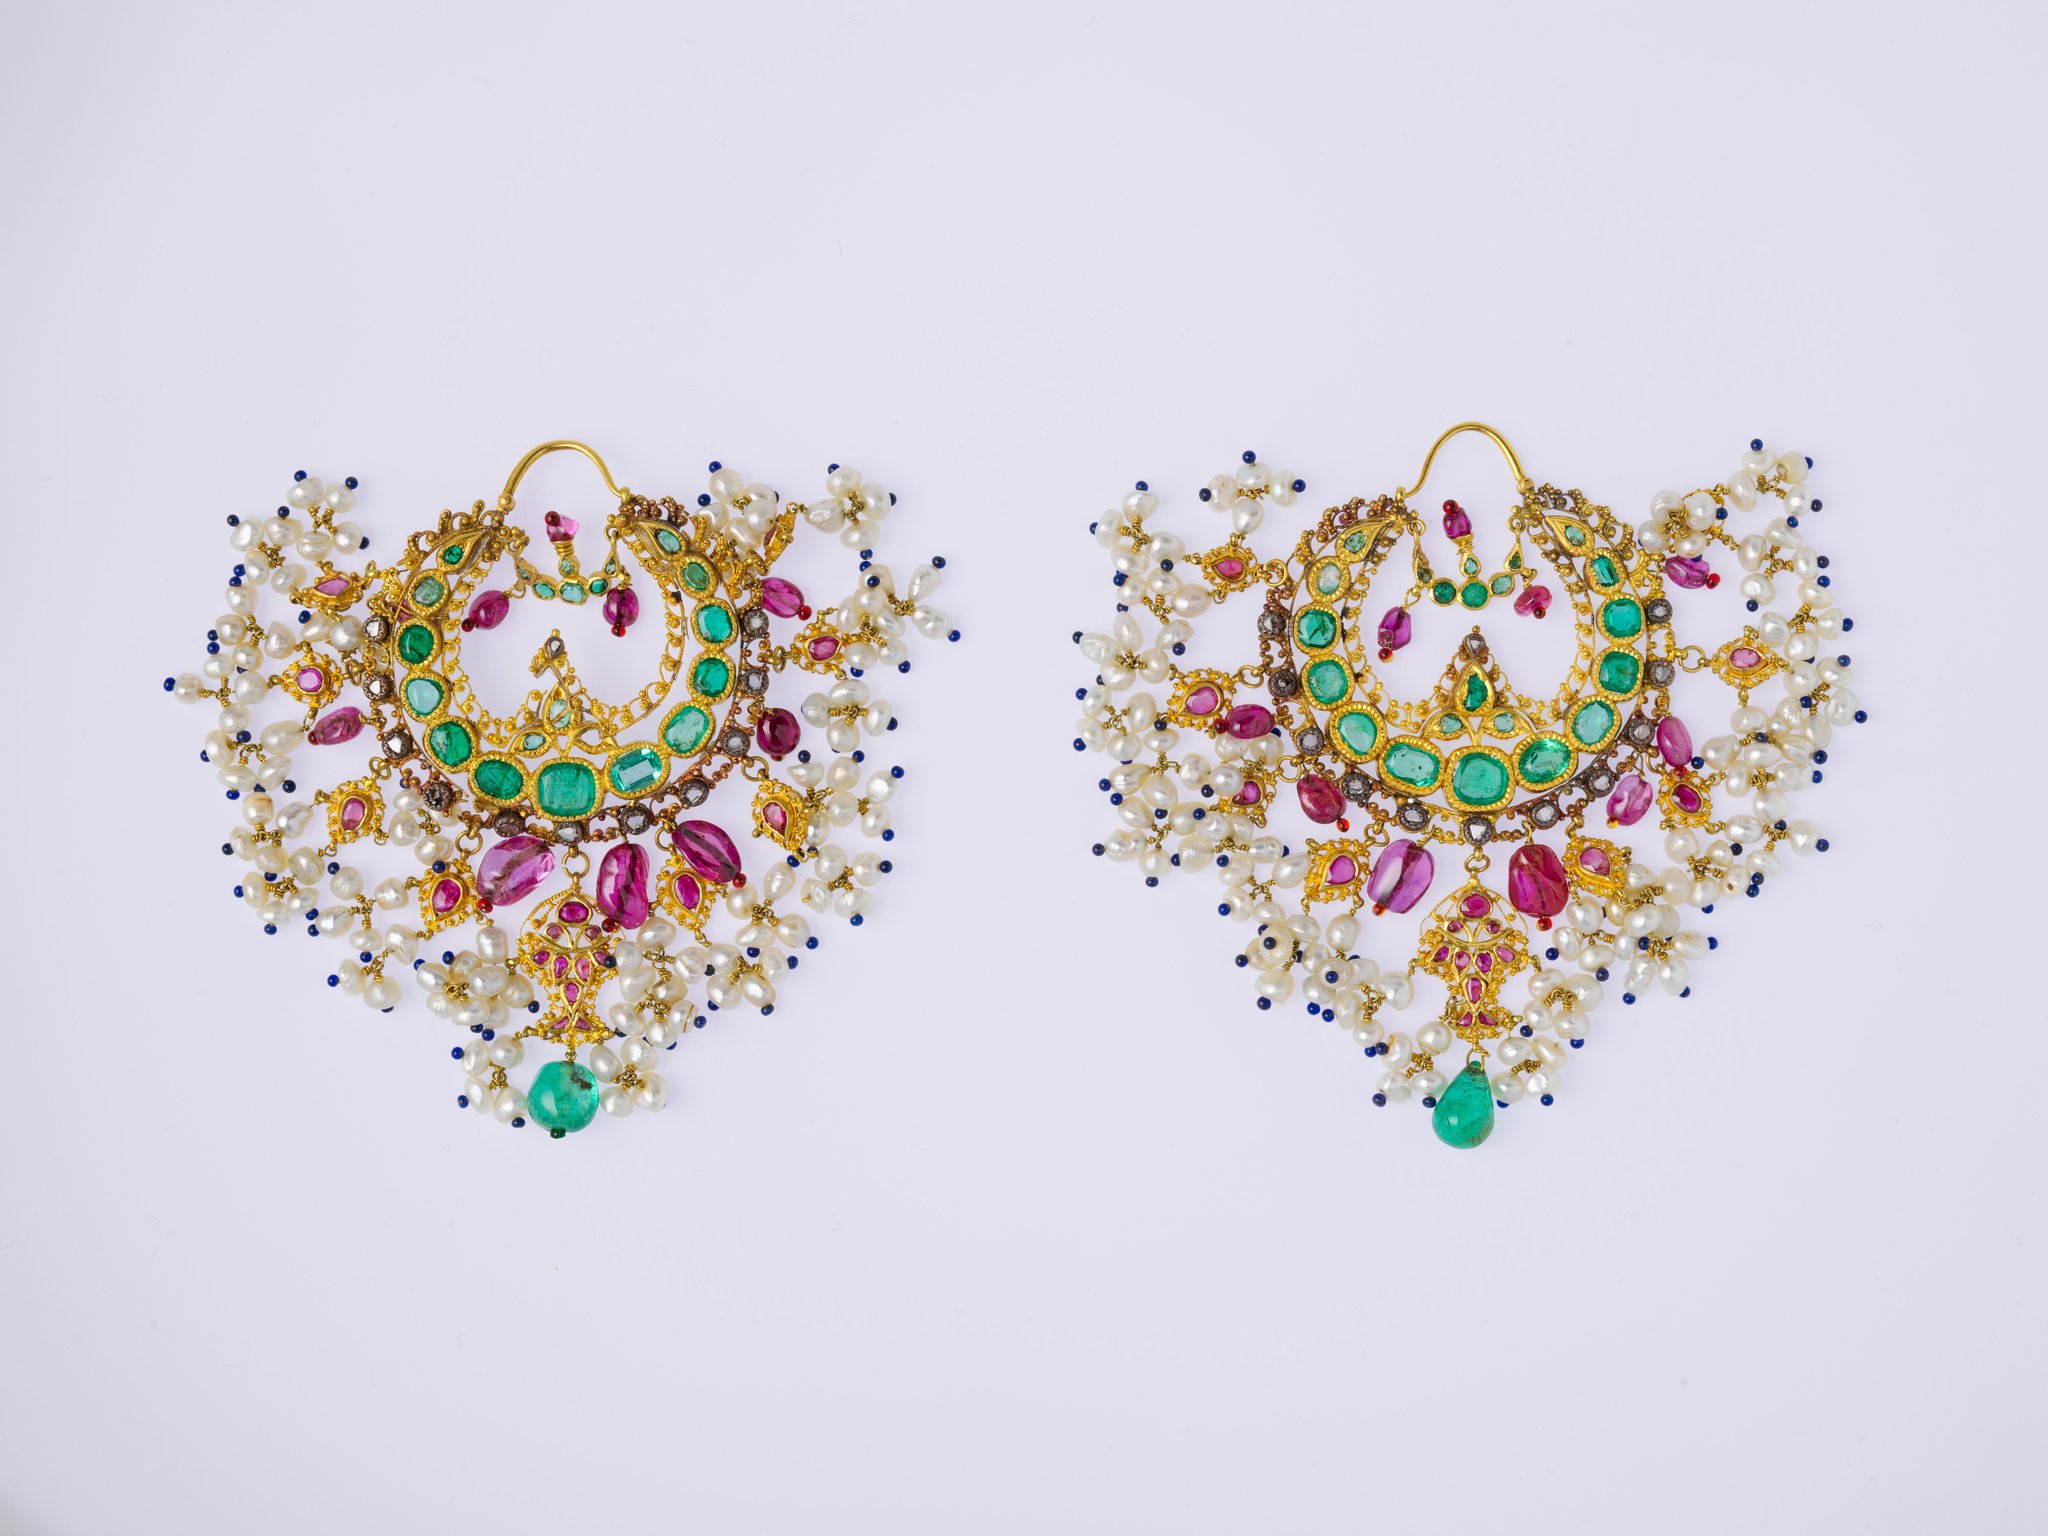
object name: pair of earring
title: Pair of Earrings (Chand Bali)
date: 1850-1900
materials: gold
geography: india